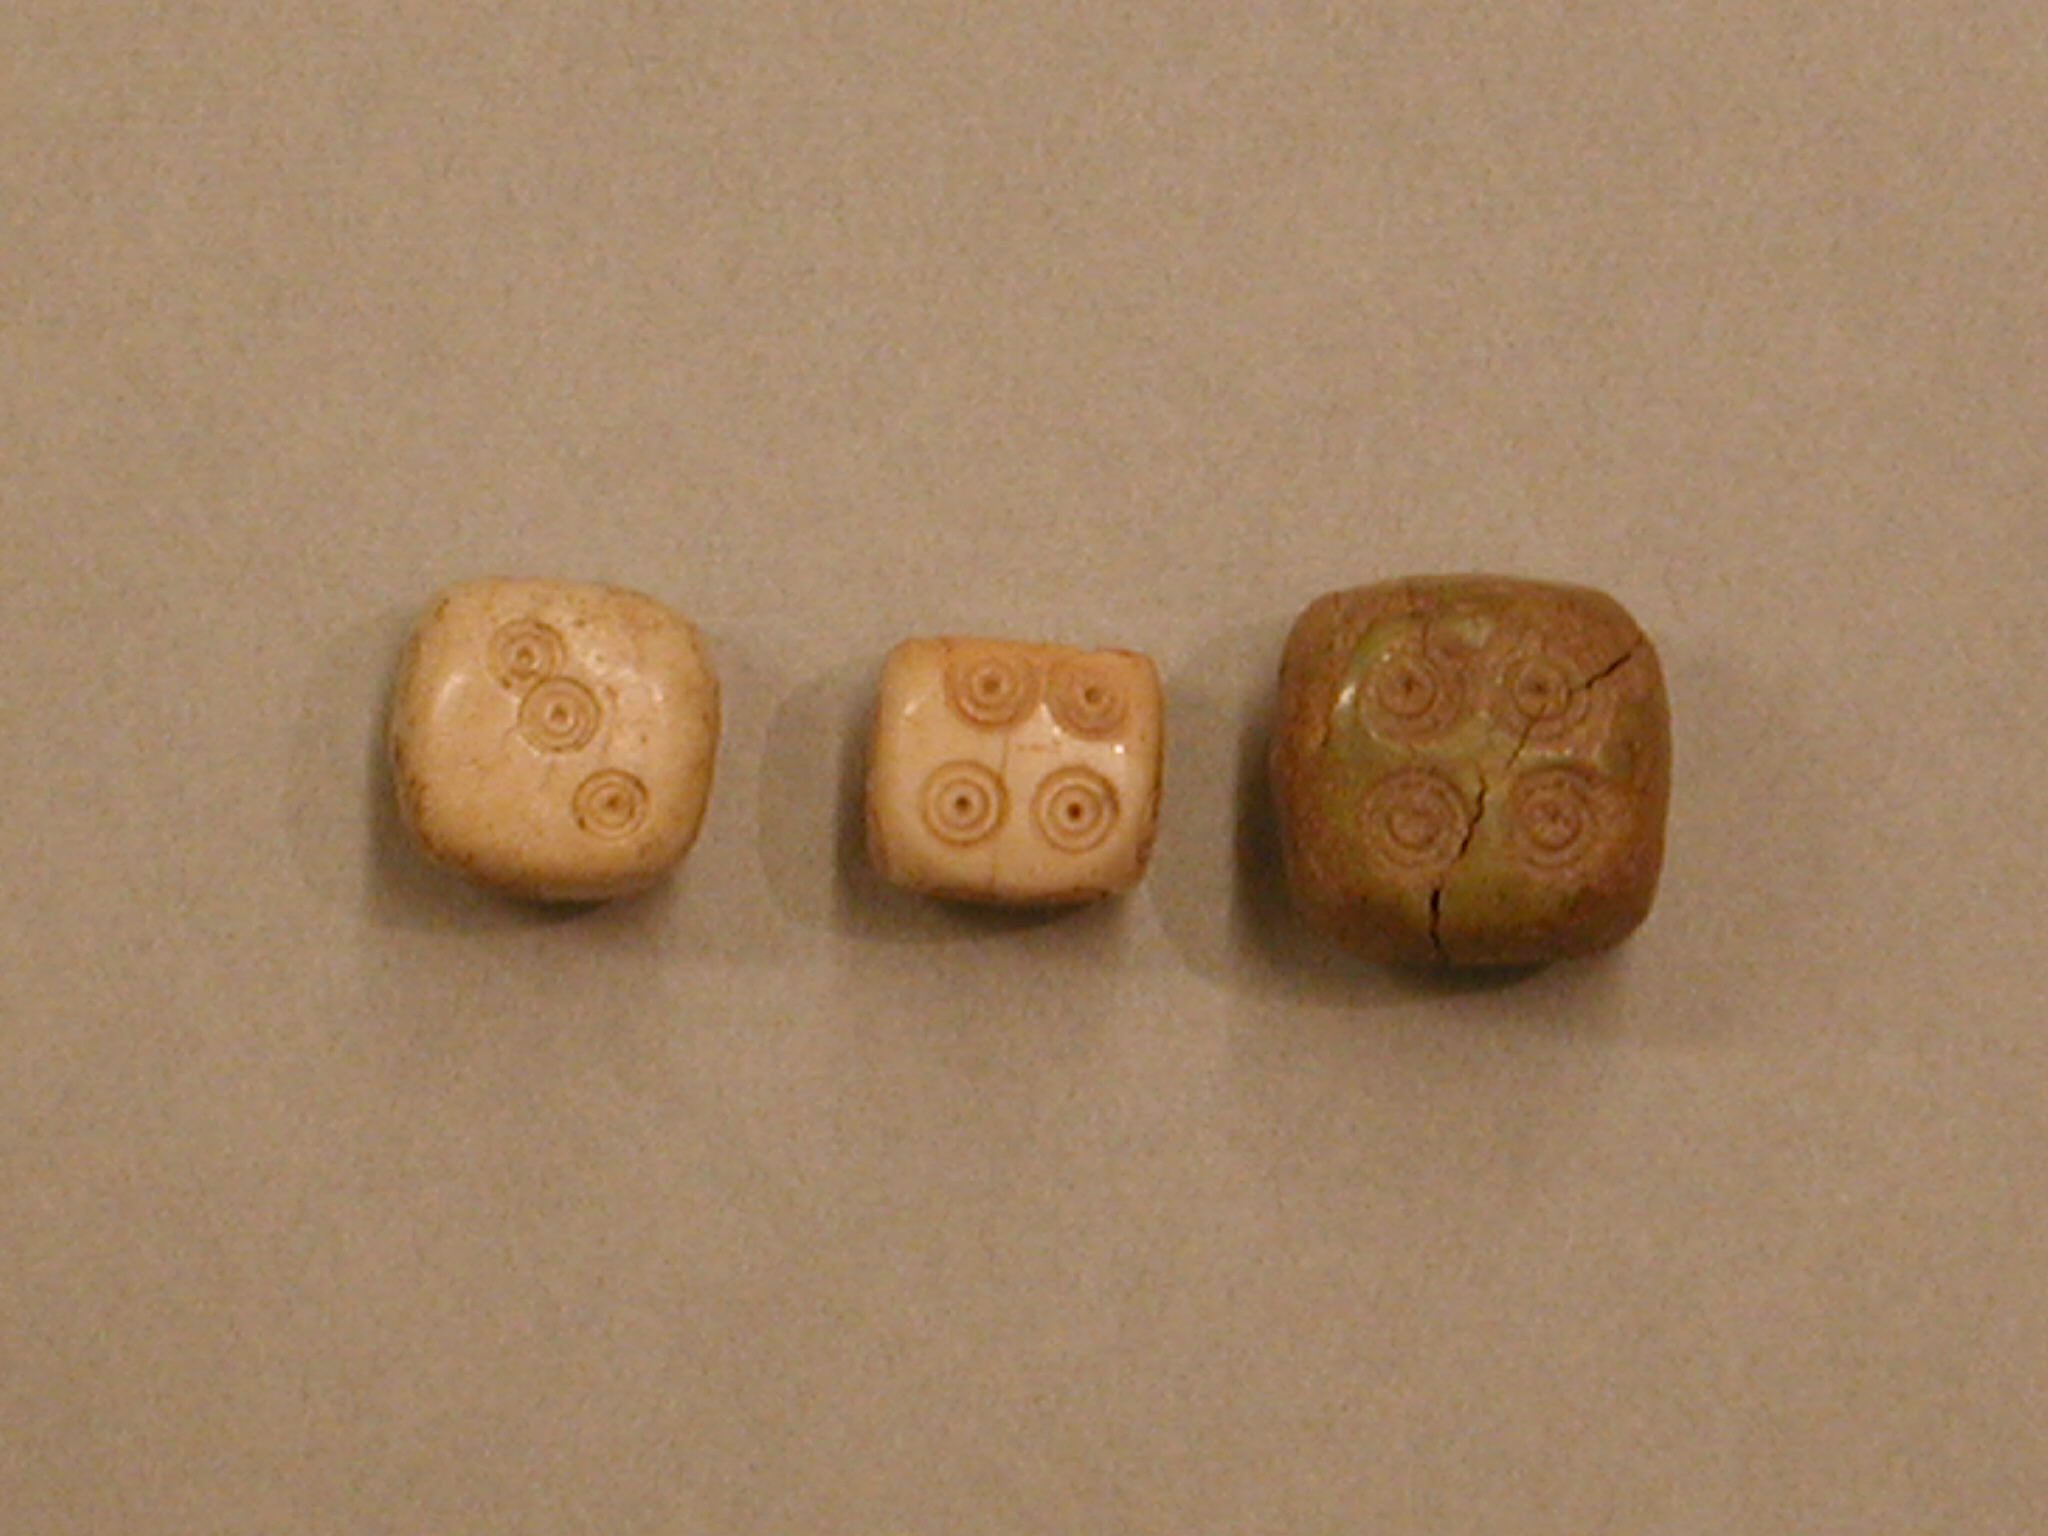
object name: dice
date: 801-1000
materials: bone, ivory, paint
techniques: incising, inlay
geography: iran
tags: dice